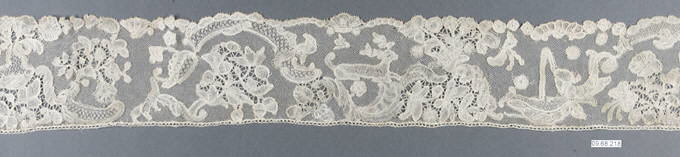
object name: strip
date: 1701-1800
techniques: lace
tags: deer